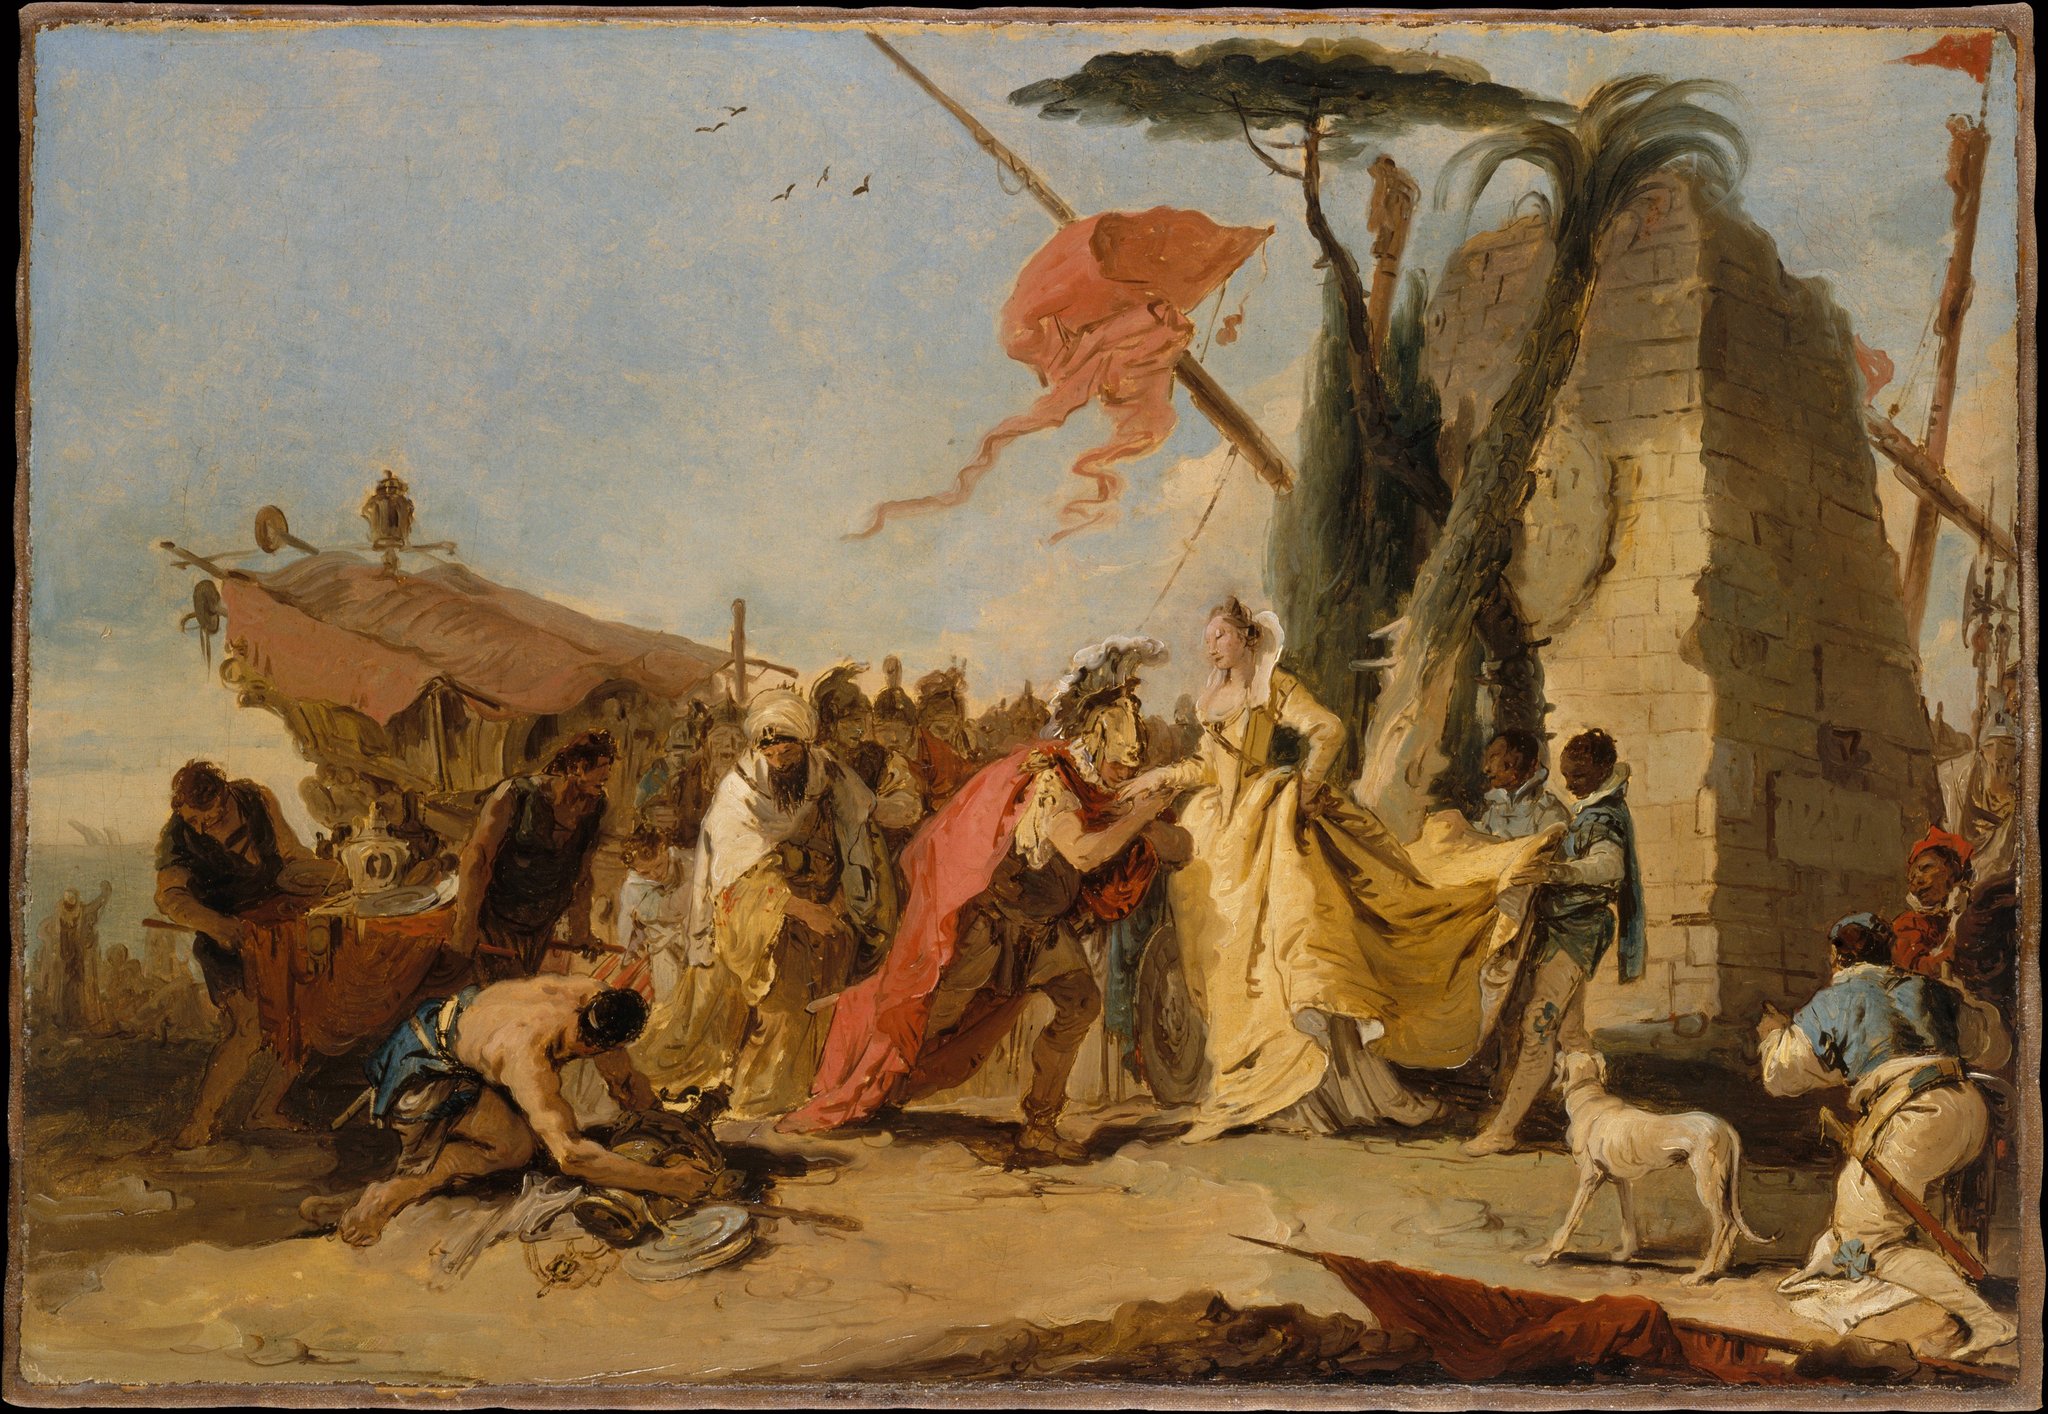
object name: painting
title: The Meeting of Antony and Cleopatra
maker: giovanni battista tiepolo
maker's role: artist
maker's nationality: italian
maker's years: 1696-1770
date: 1745-1747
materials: canvas, oil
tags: cleopatra,mark antony,dogs,flags